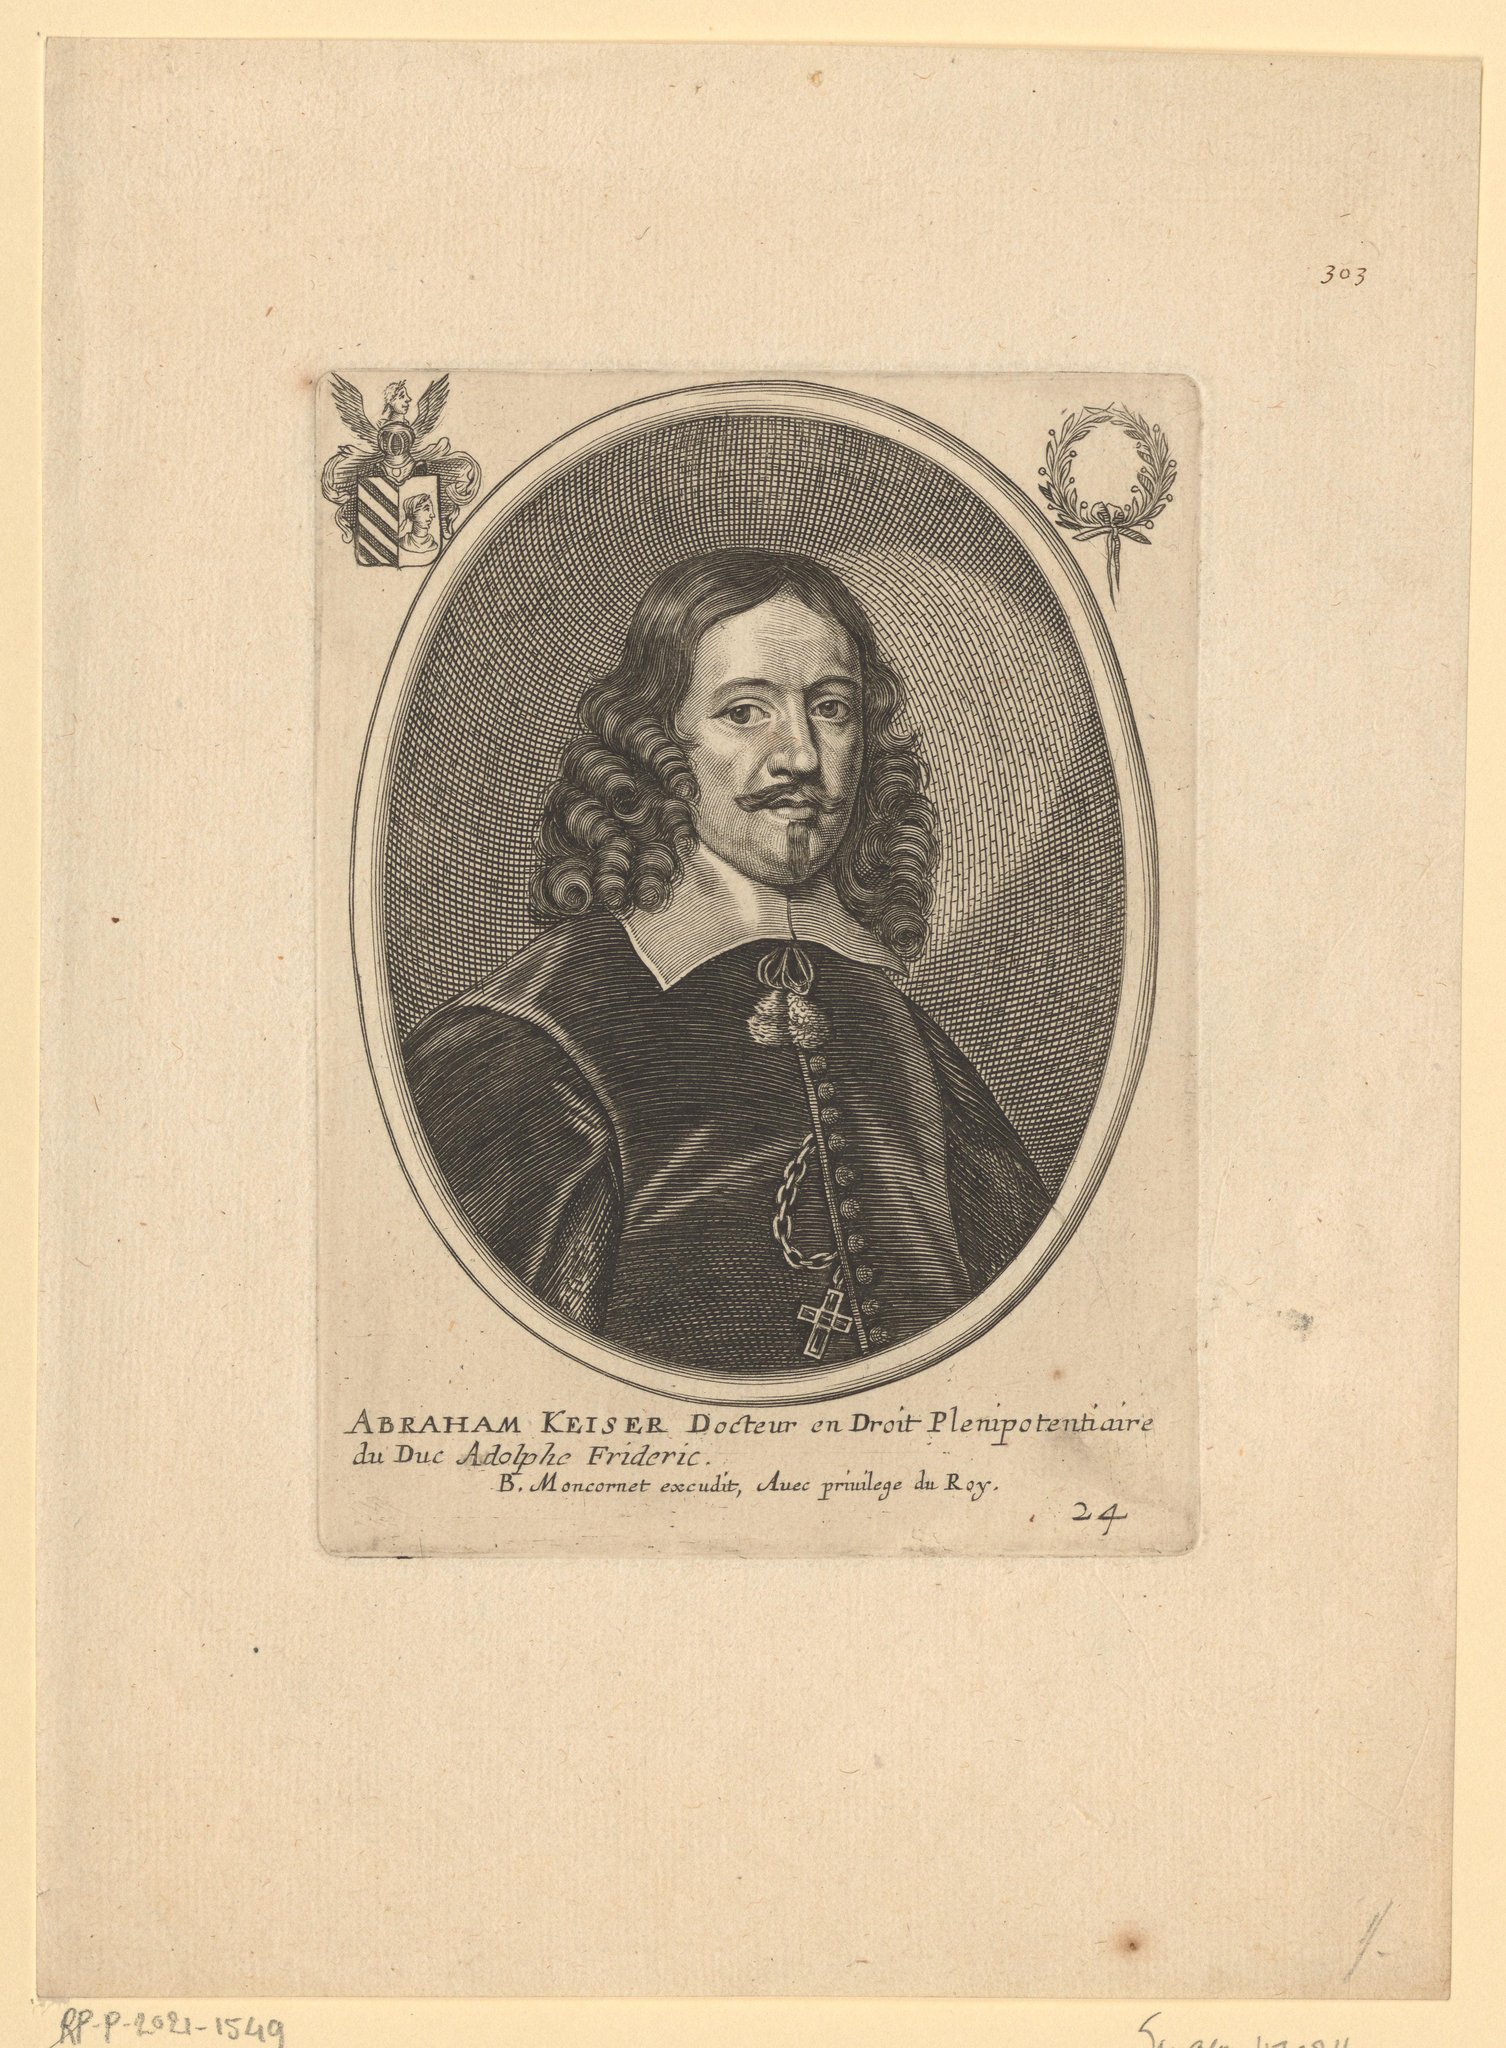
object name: print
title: Portret van Abraham Keyser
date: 1610-1668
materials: paper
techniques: engraving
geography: france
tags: historical persons, armorial bearing, heraldry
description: Rechtsonder genummerd: 24. Links naast het portret zijn wapenschild.